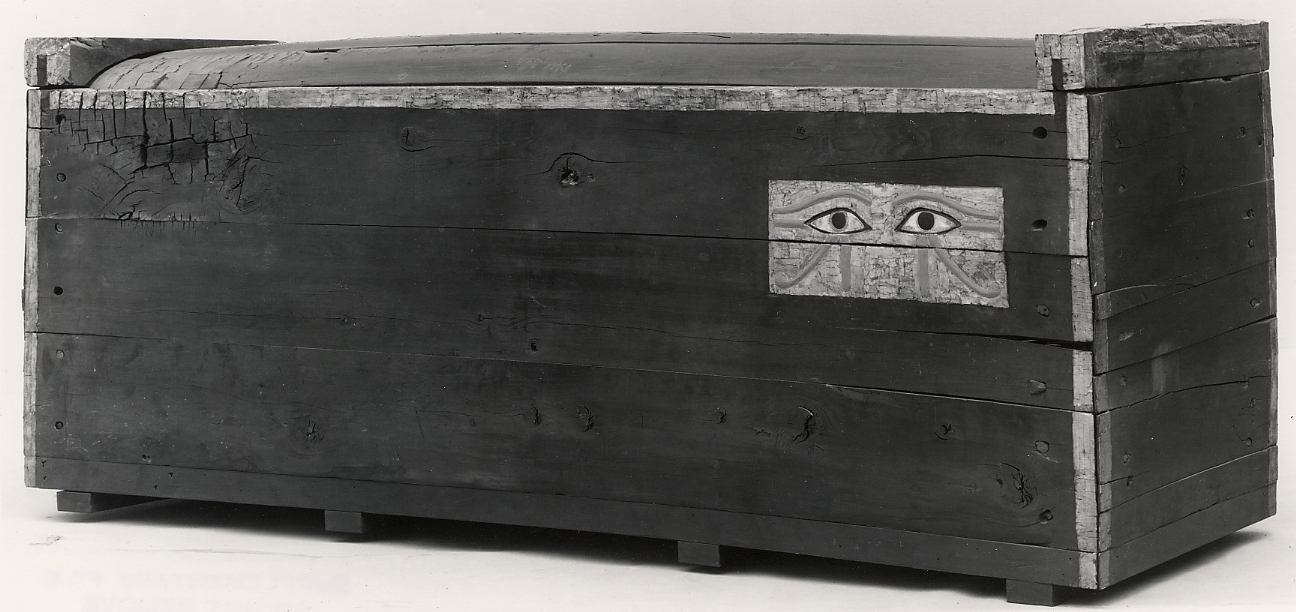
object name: coffin, senebtisi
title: Outer coffin of Senebtisi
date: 1850-1775 BCE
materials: wood, gold leaf, obsidian, paint, panel, plaster, stone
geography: egypt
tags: eyes,coffins